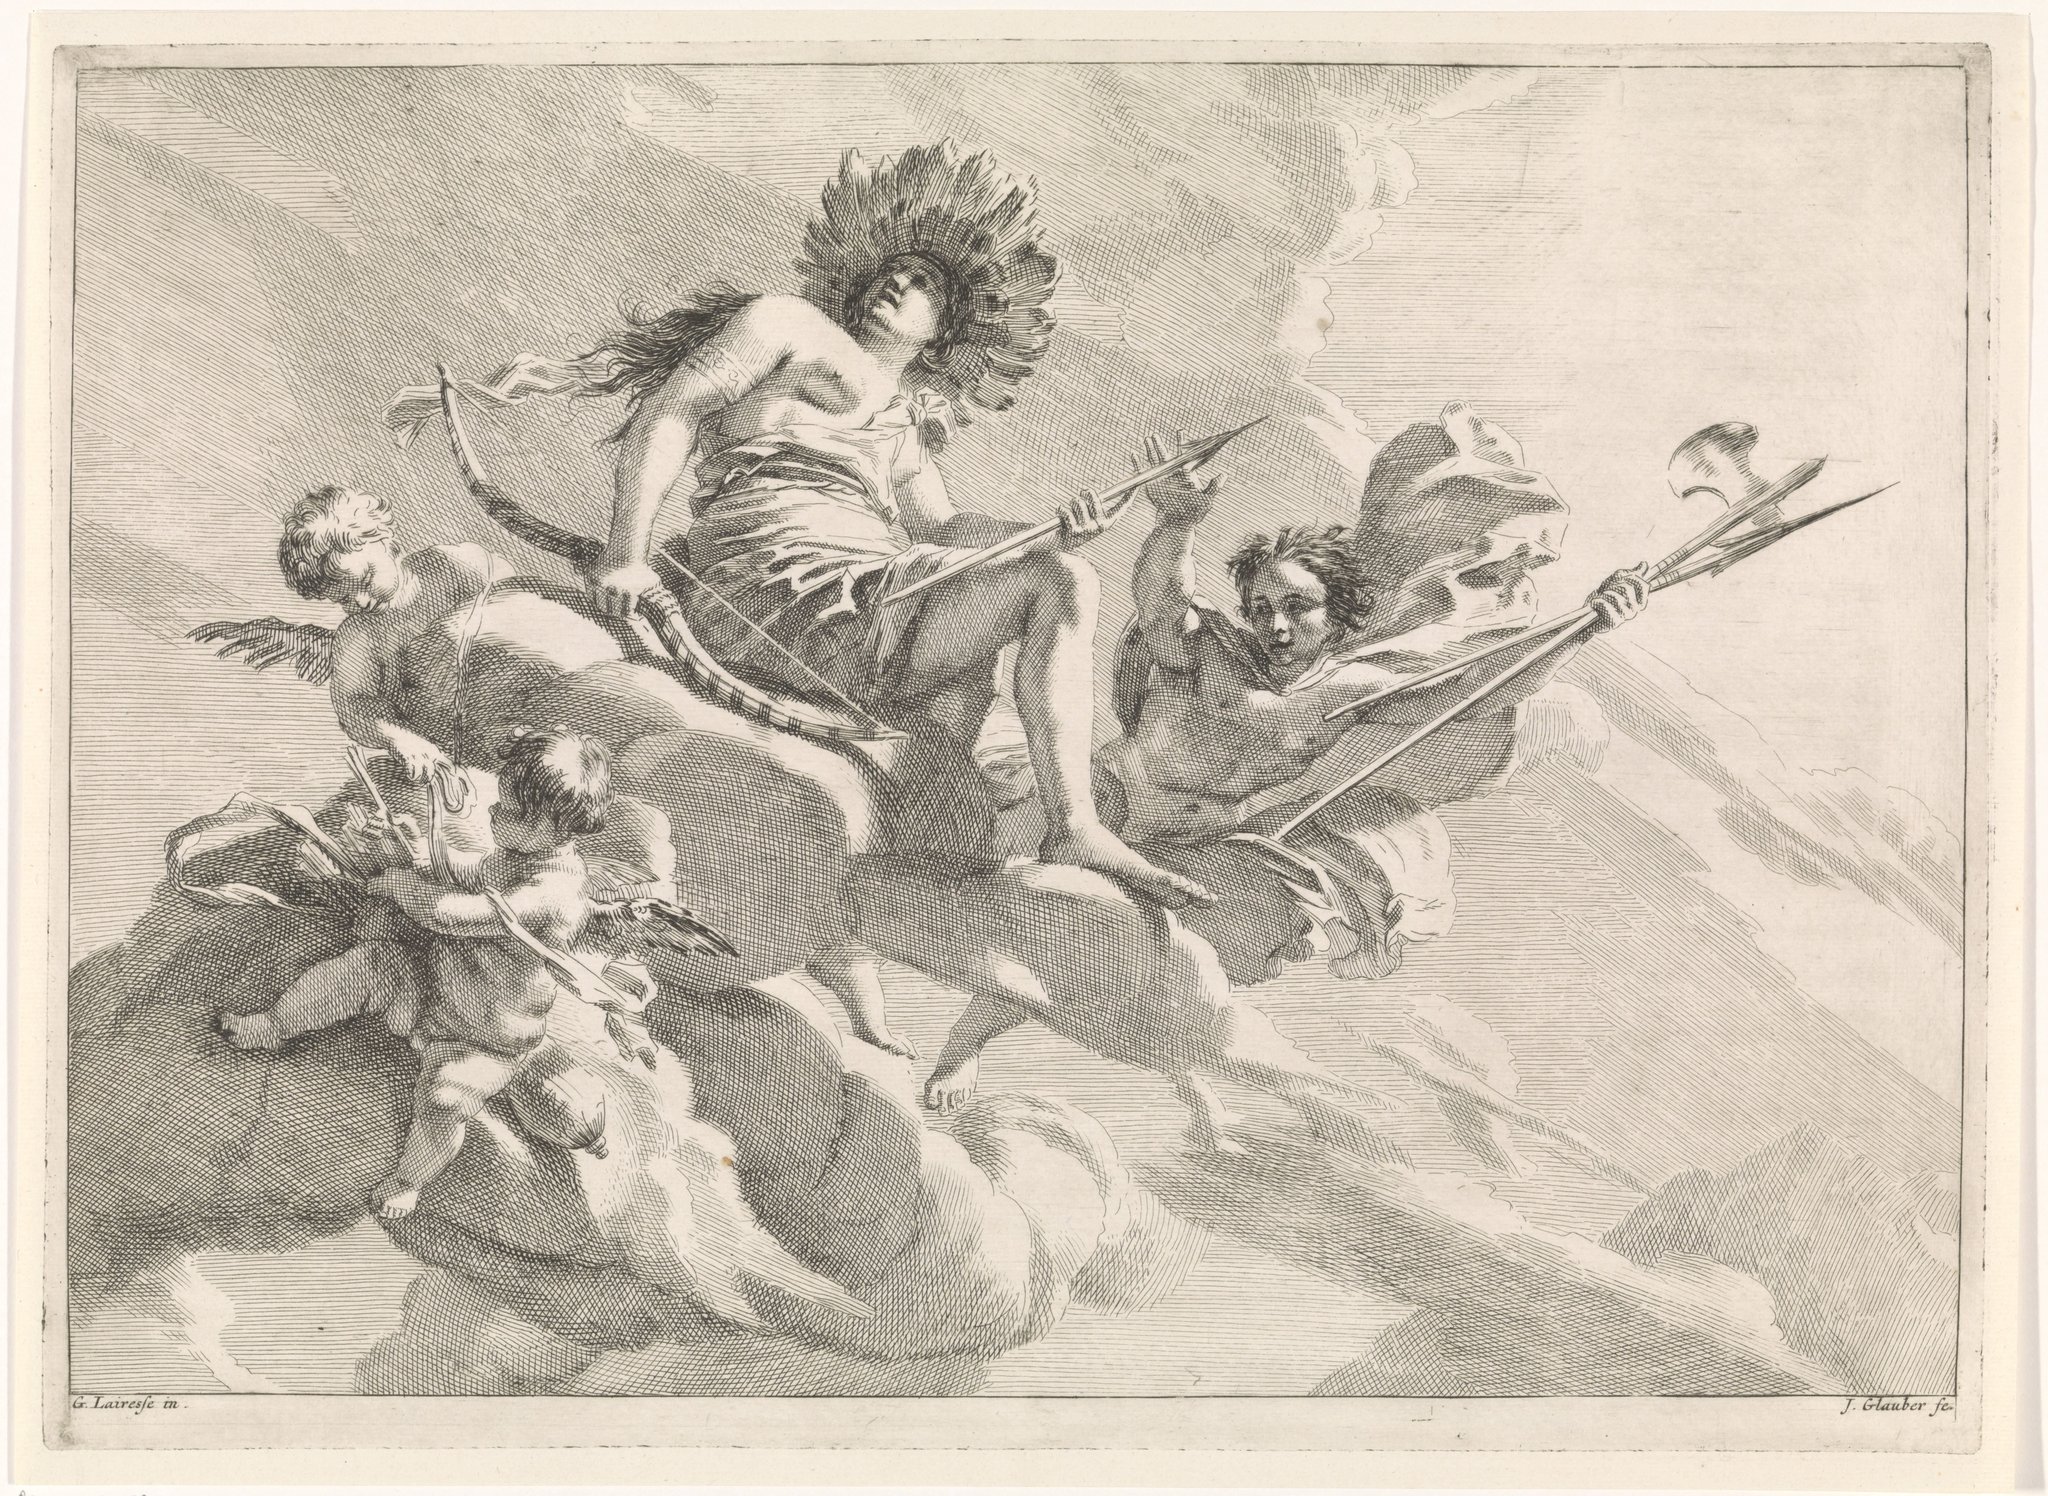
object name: print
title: Diana met pijl en boog op een wolk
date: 1656-1726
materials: paper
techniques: etching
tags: (story of) diana (artemis), cupids: 'amores', 'amoretti', 'putti'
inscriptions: collector's mark: Lugt 2228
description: Diana zit op een wolk, pijl en boog in de hand. Ze wordt omringd door twee putti en een man met een bijl en een speer. De prent maakt deel uit van een serie met Bijbelse, mythologische en allegorische voorstellingen.